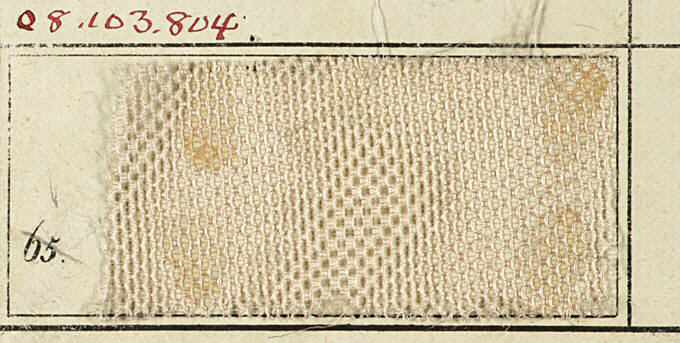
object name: ribbon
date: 1701-1900